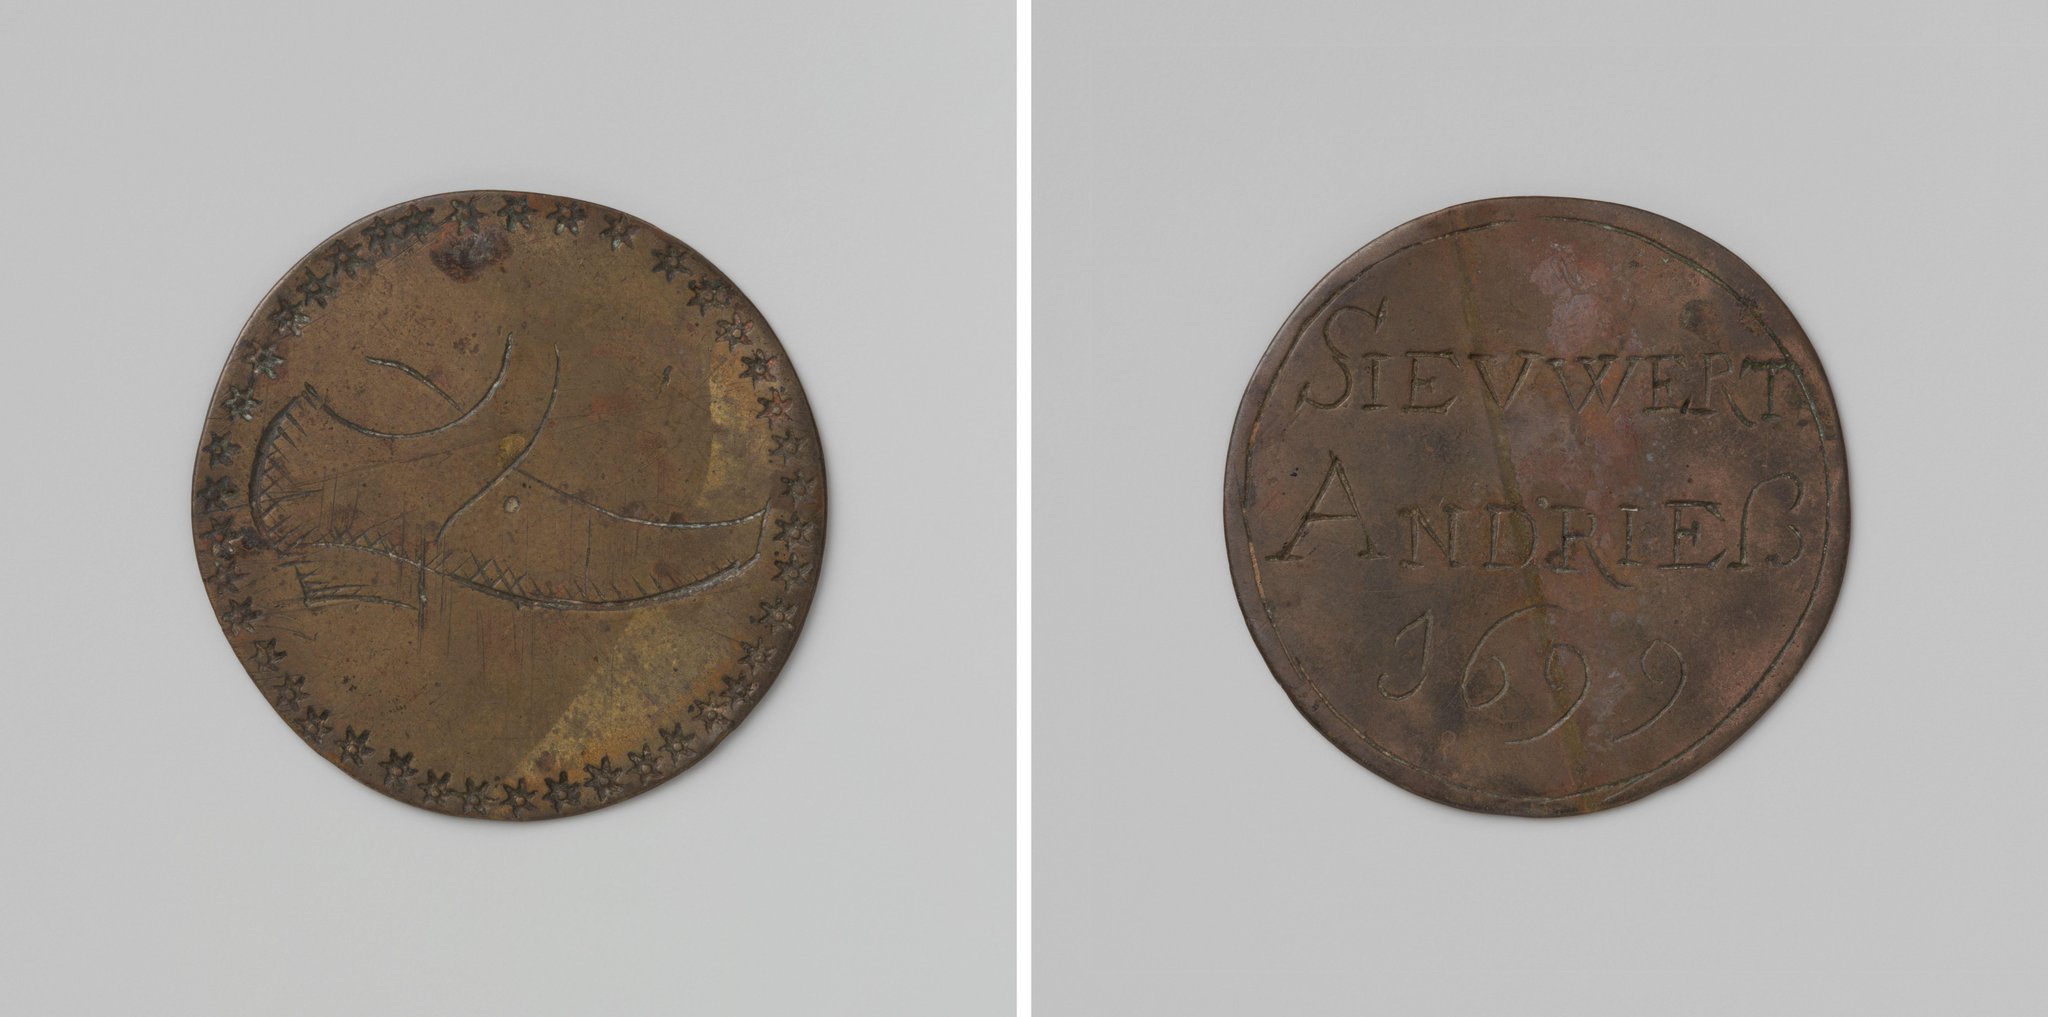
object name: medal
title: Schoenmakersgilde, gildepenning van Sieuwert Andriesz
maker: Anonymous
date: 1699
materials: brass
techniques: engraving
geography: netherlands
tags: sieuwert andriesz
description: Messing penning. Voorzijde: schoen binnen sterrenkrans. Keerzijde: opschrift en jaartal